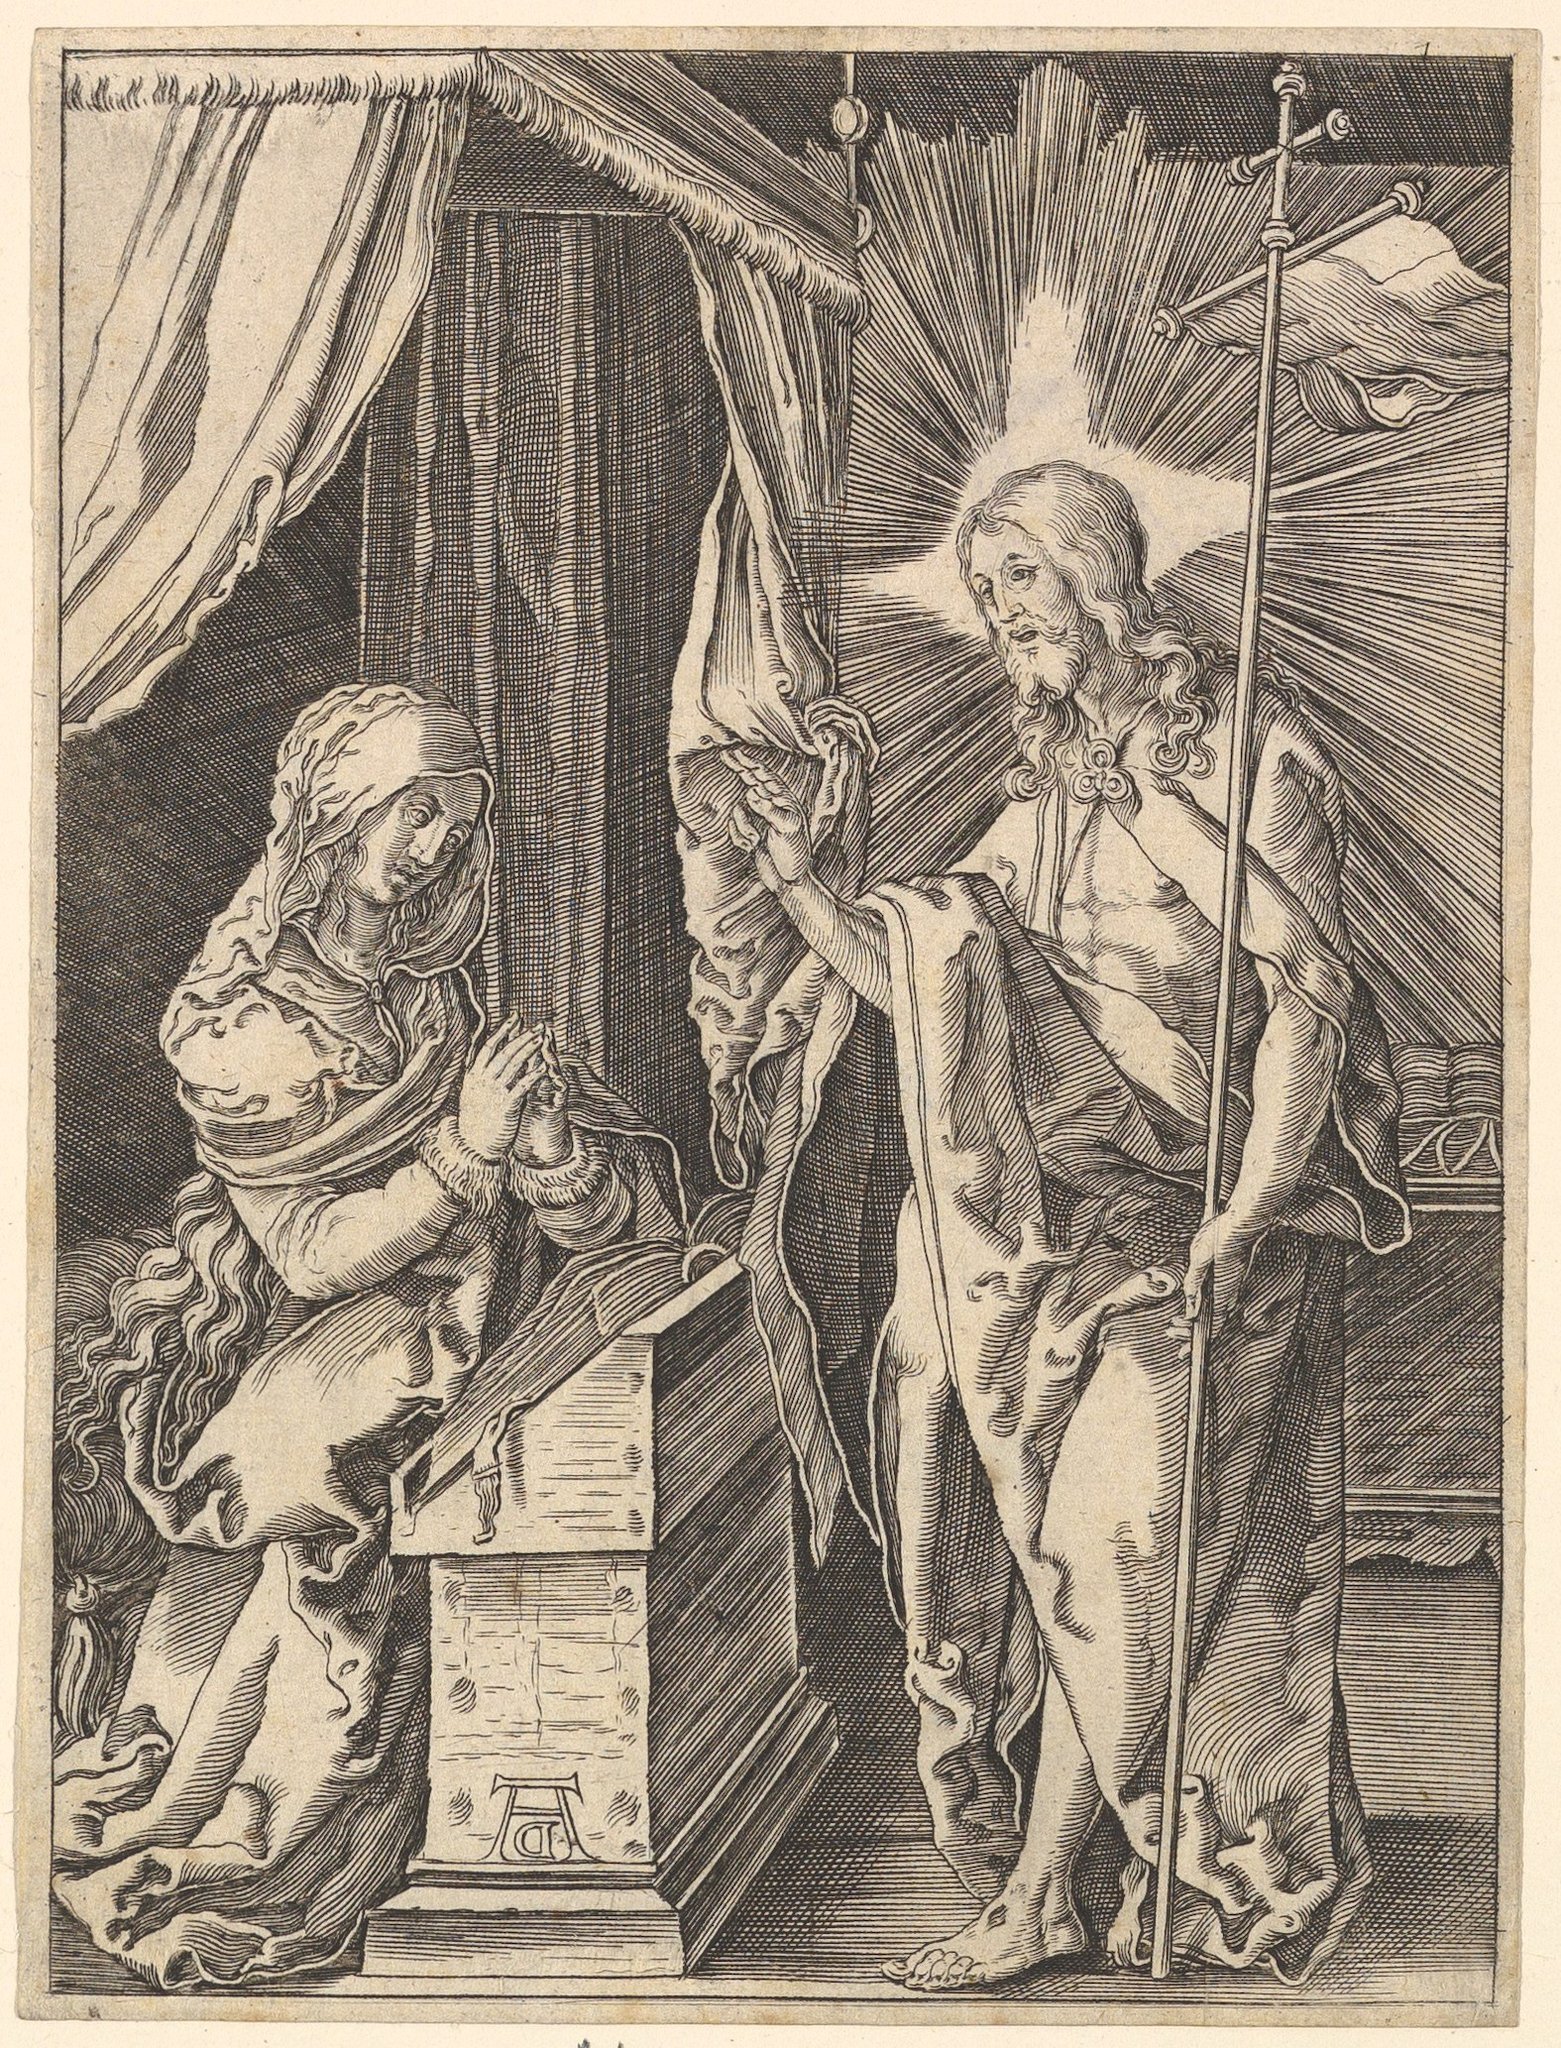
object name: print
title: Engraved copies of The Little Passion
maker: albrecht dürer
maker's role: artist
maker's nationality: german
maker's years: 1471-1528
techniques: engraving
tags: women,jesus